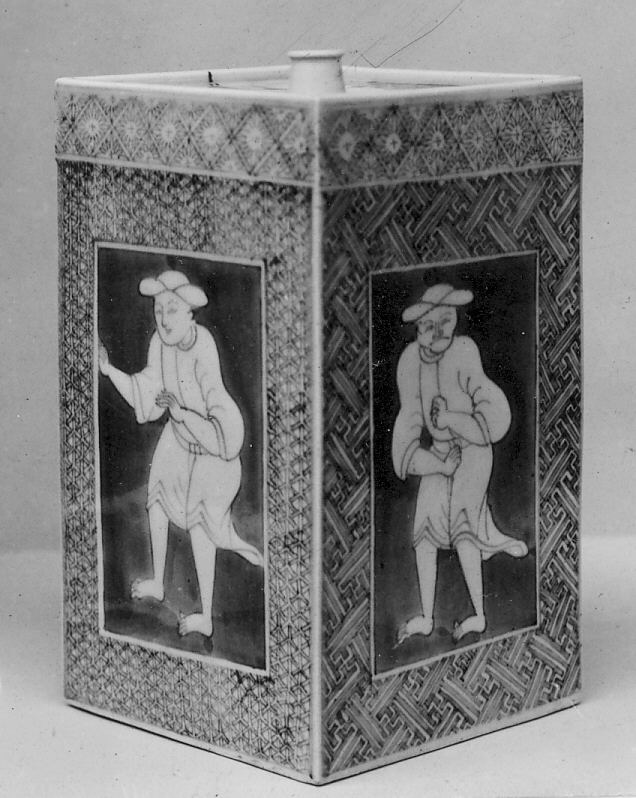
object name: sake bottle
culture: japanese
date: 1780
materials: glaze, porcelain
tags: men